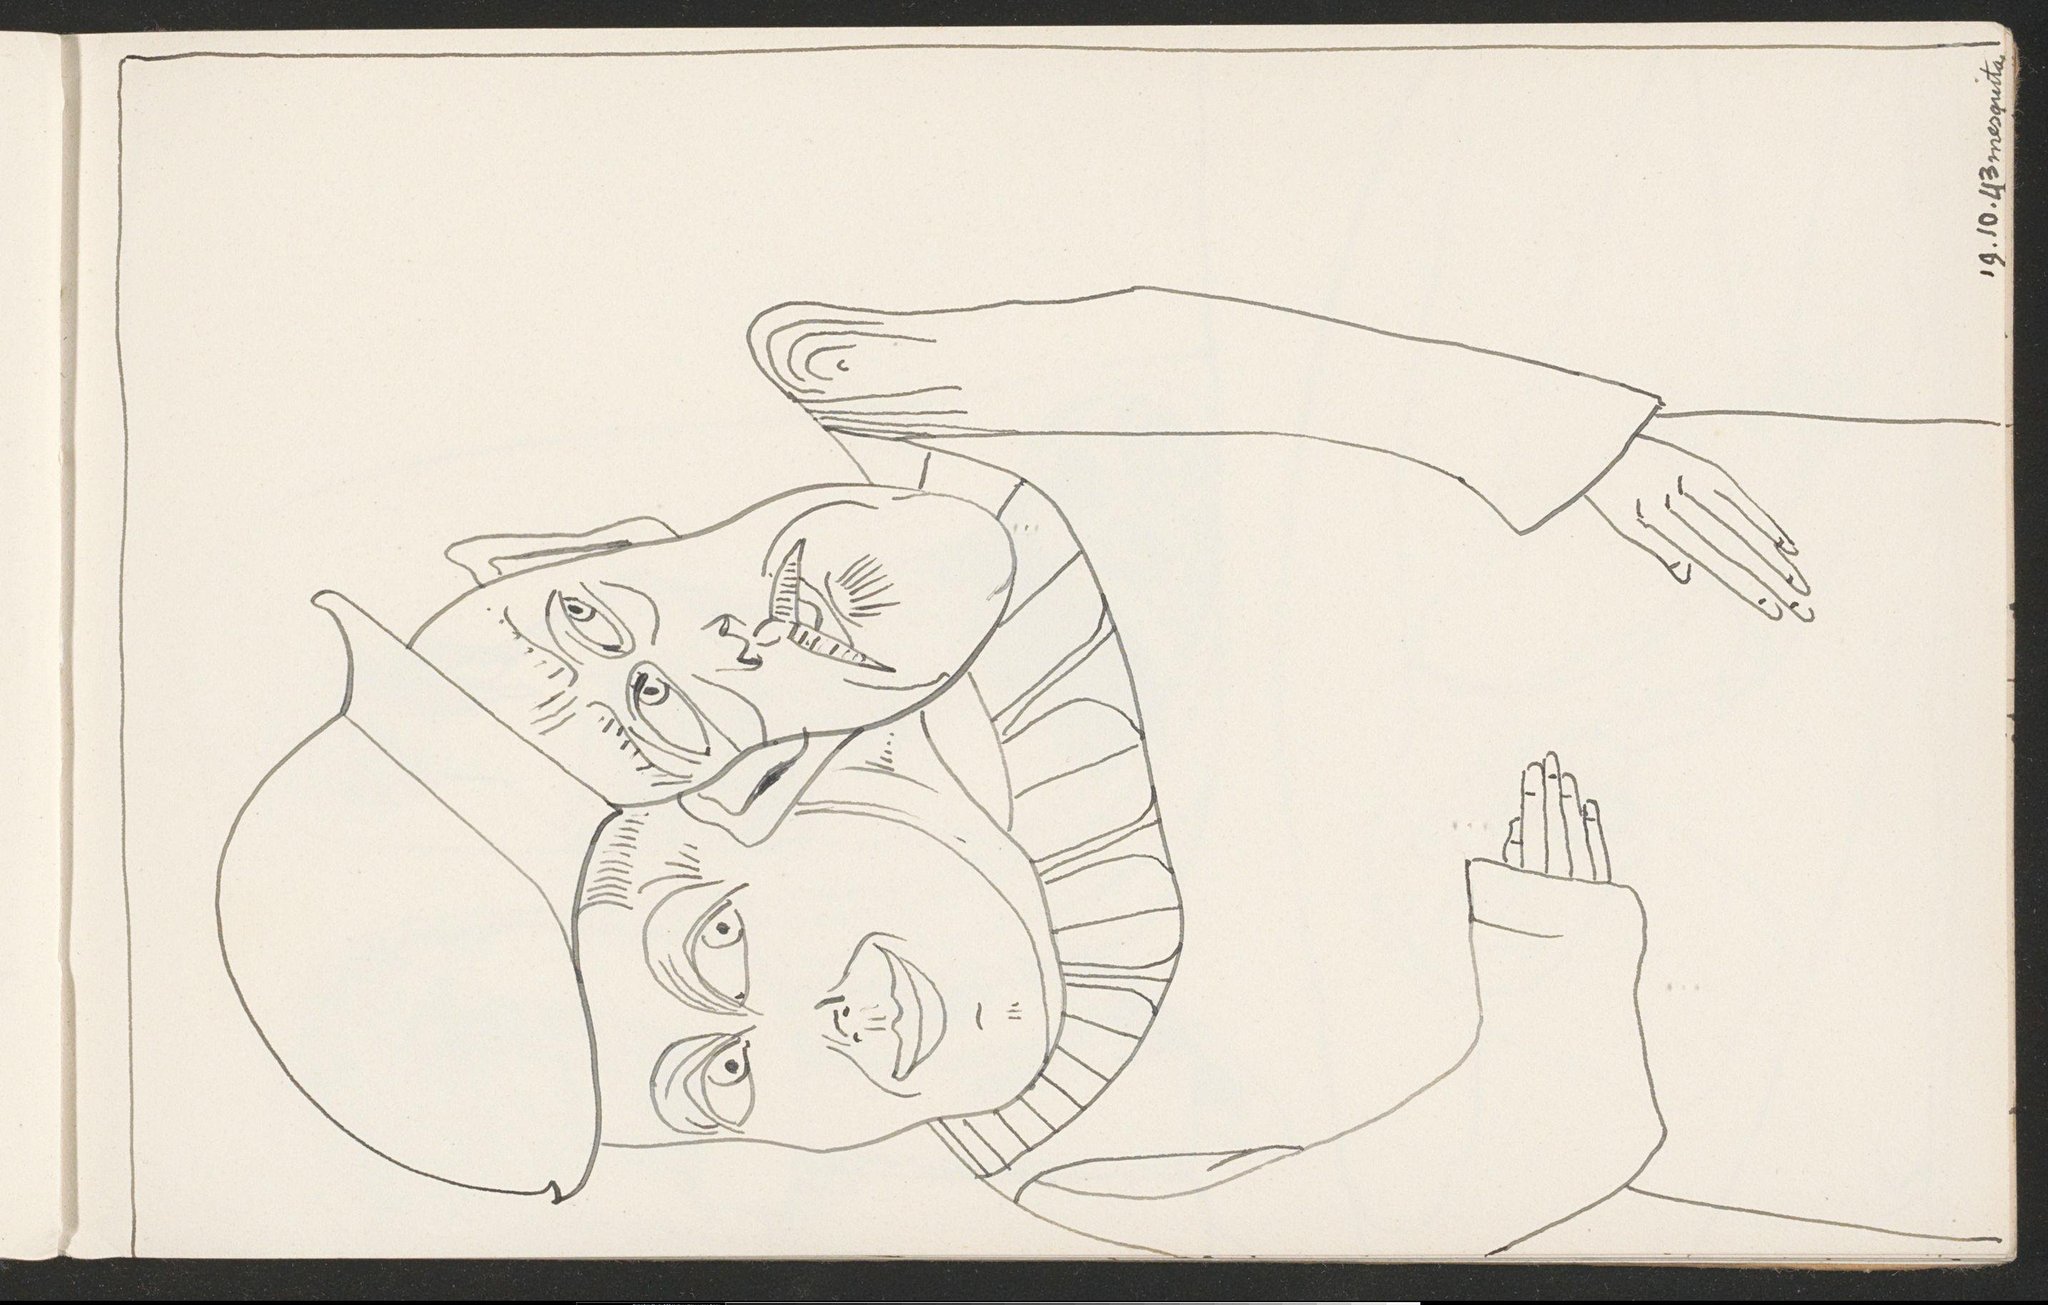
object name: sketchbook leaf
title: Figuur met twee mannenkoppen op één lichaam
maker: samuel jessurun de mesquita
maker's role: draughtsman, print maker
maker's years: 1868-1944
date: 1943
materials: ink, paper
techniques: pen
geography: amsterdam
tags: head (human), moustache, adult man, anthropomorphic beings (legendary or not) with heads, limbs or organs of an abnormal number, in abnormal places or of an abnormal shape)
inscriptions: signature and date: ‘19.10.43 mesquita’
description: De linkerfiguur heeft een breed hoofd, de rechterfiguur een smaller hoofd met een snor. Samen dragen de koppen één pet. Blad 12 recto uit een schetsboek met 18 bladen.